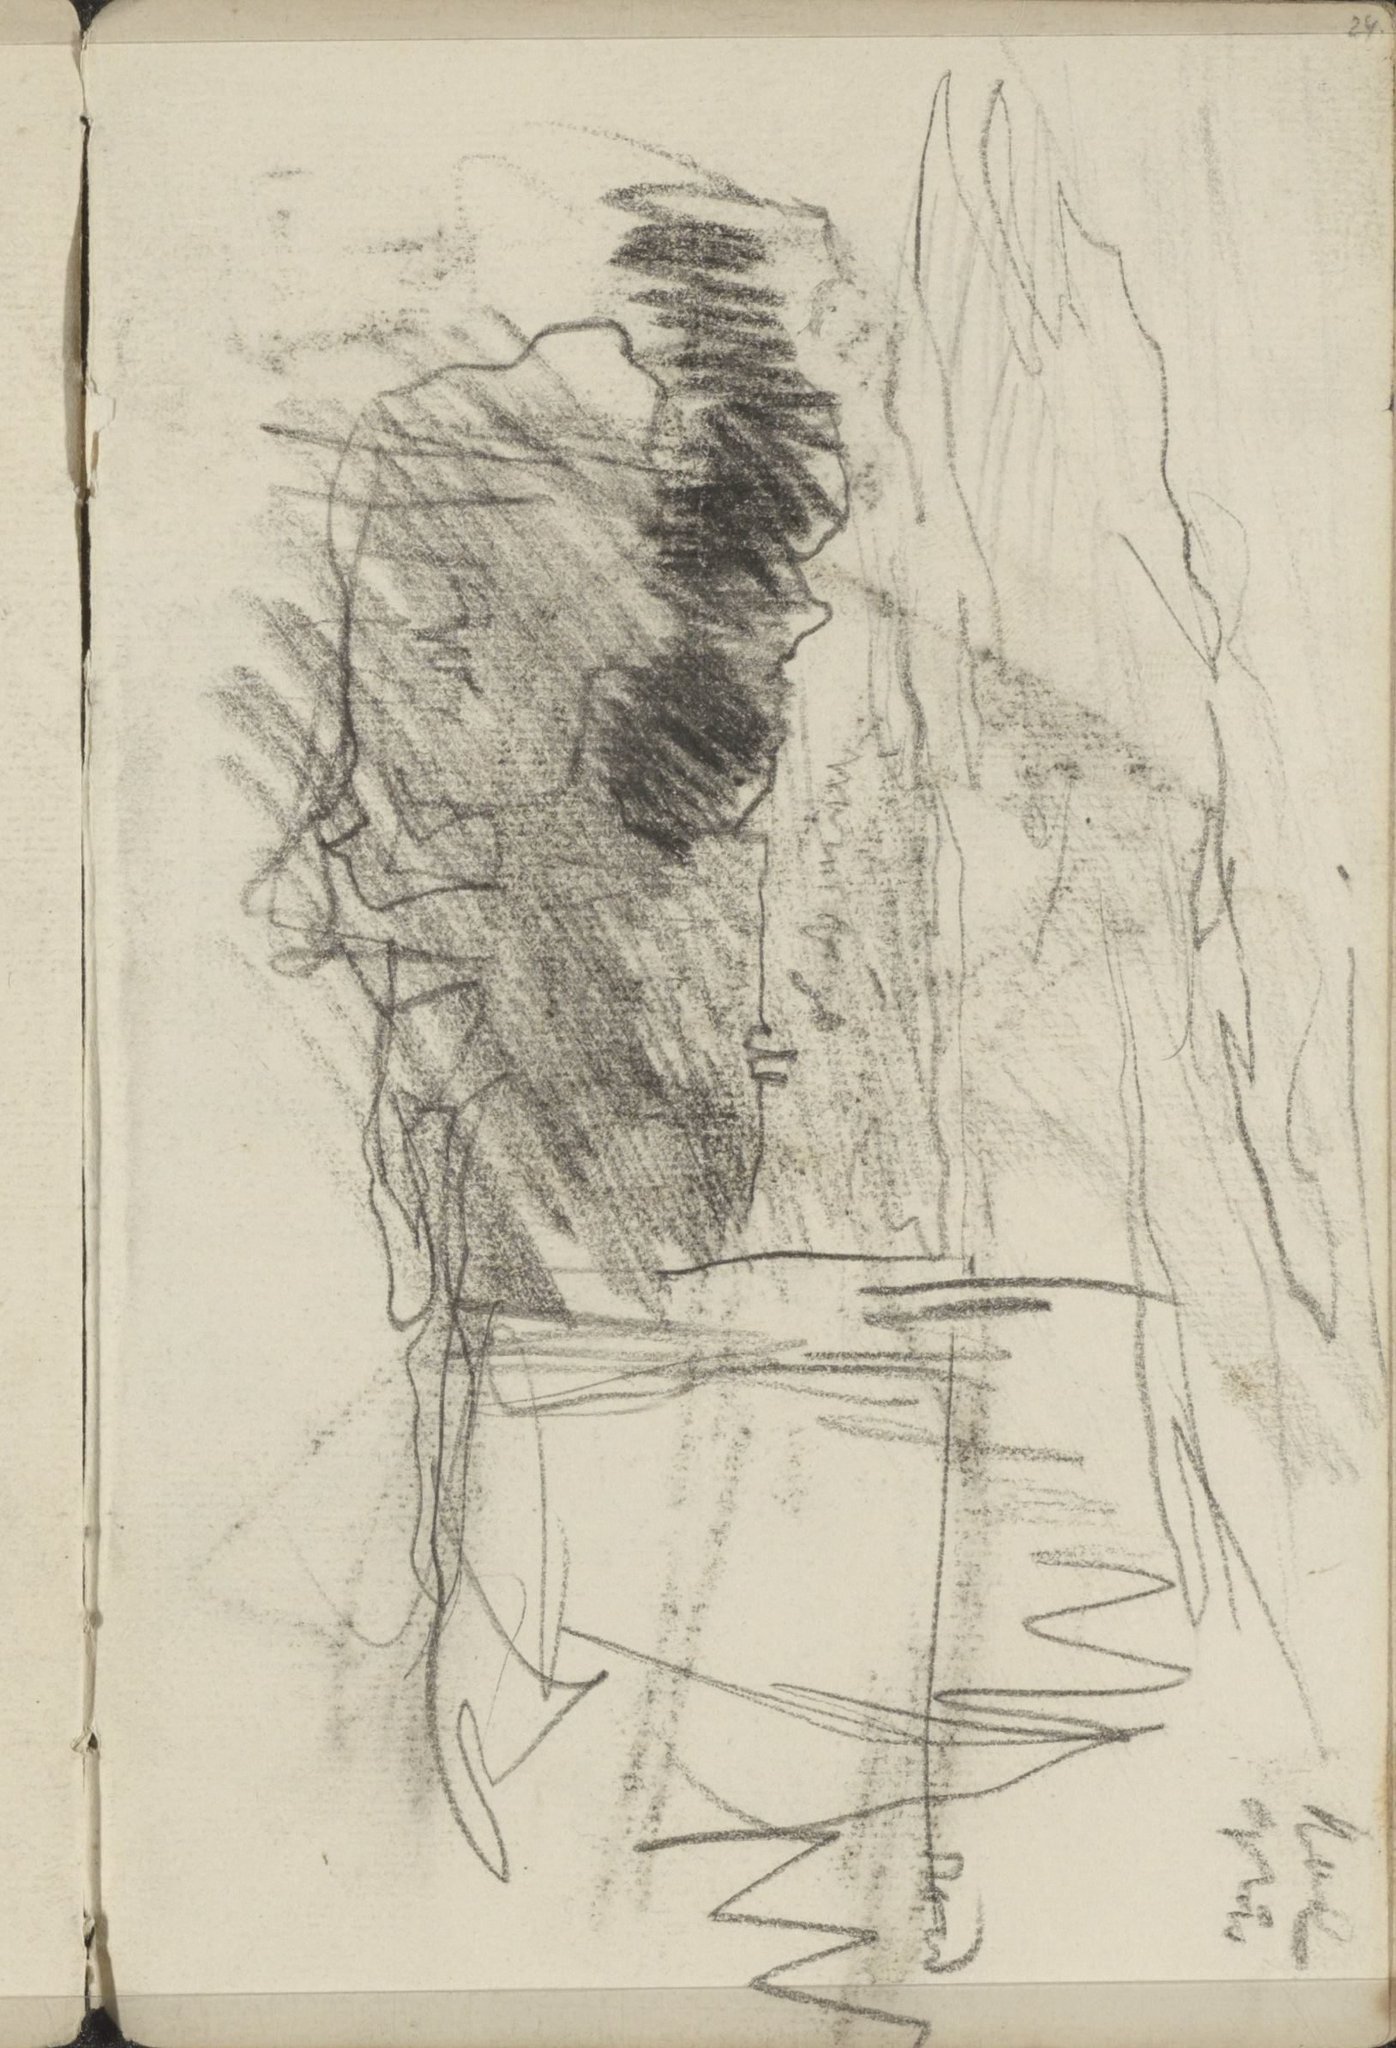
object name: sketchbook leaf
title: Studie, mogelijk van een stadsgezicht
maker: george hendrik breitner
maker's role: draughtsman, painter, print maker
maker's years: 1857-1923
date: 1886-1903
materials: chalk, paper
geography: amsterdam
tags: city-view, and landscape with man-made constructions, amsterdam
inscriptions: kleurnotitie, handgeschreven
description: Pagina 24 uit een schetsboek met 15 bladen.